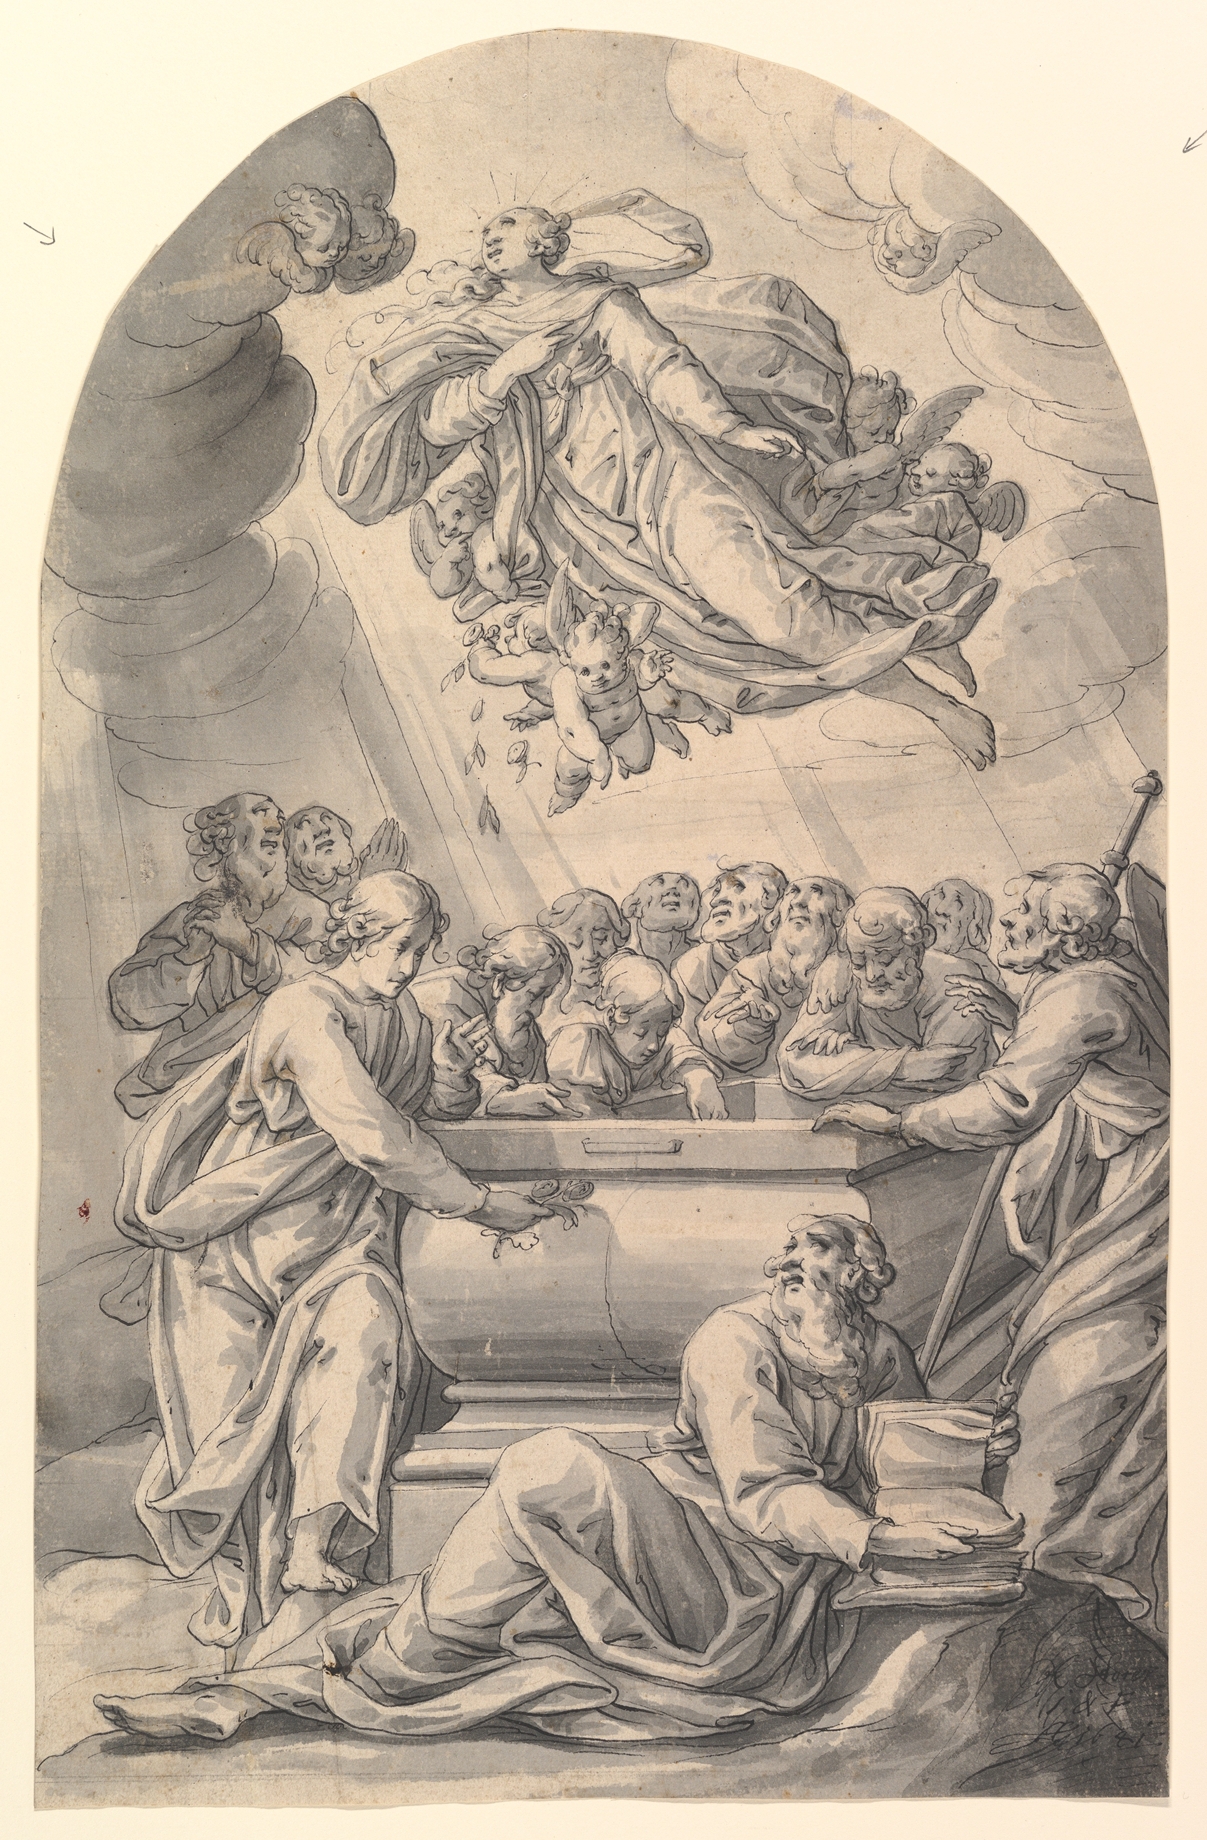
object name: drawing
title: The Assumption of the Virgin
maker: johann christophorus storer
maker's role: artist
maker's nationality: german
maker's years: 1611-1671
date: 1641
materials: chalk, graphite, ink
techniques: pen, drawing, transfer, wash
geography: germany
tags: men,angels,assumption of the virgin